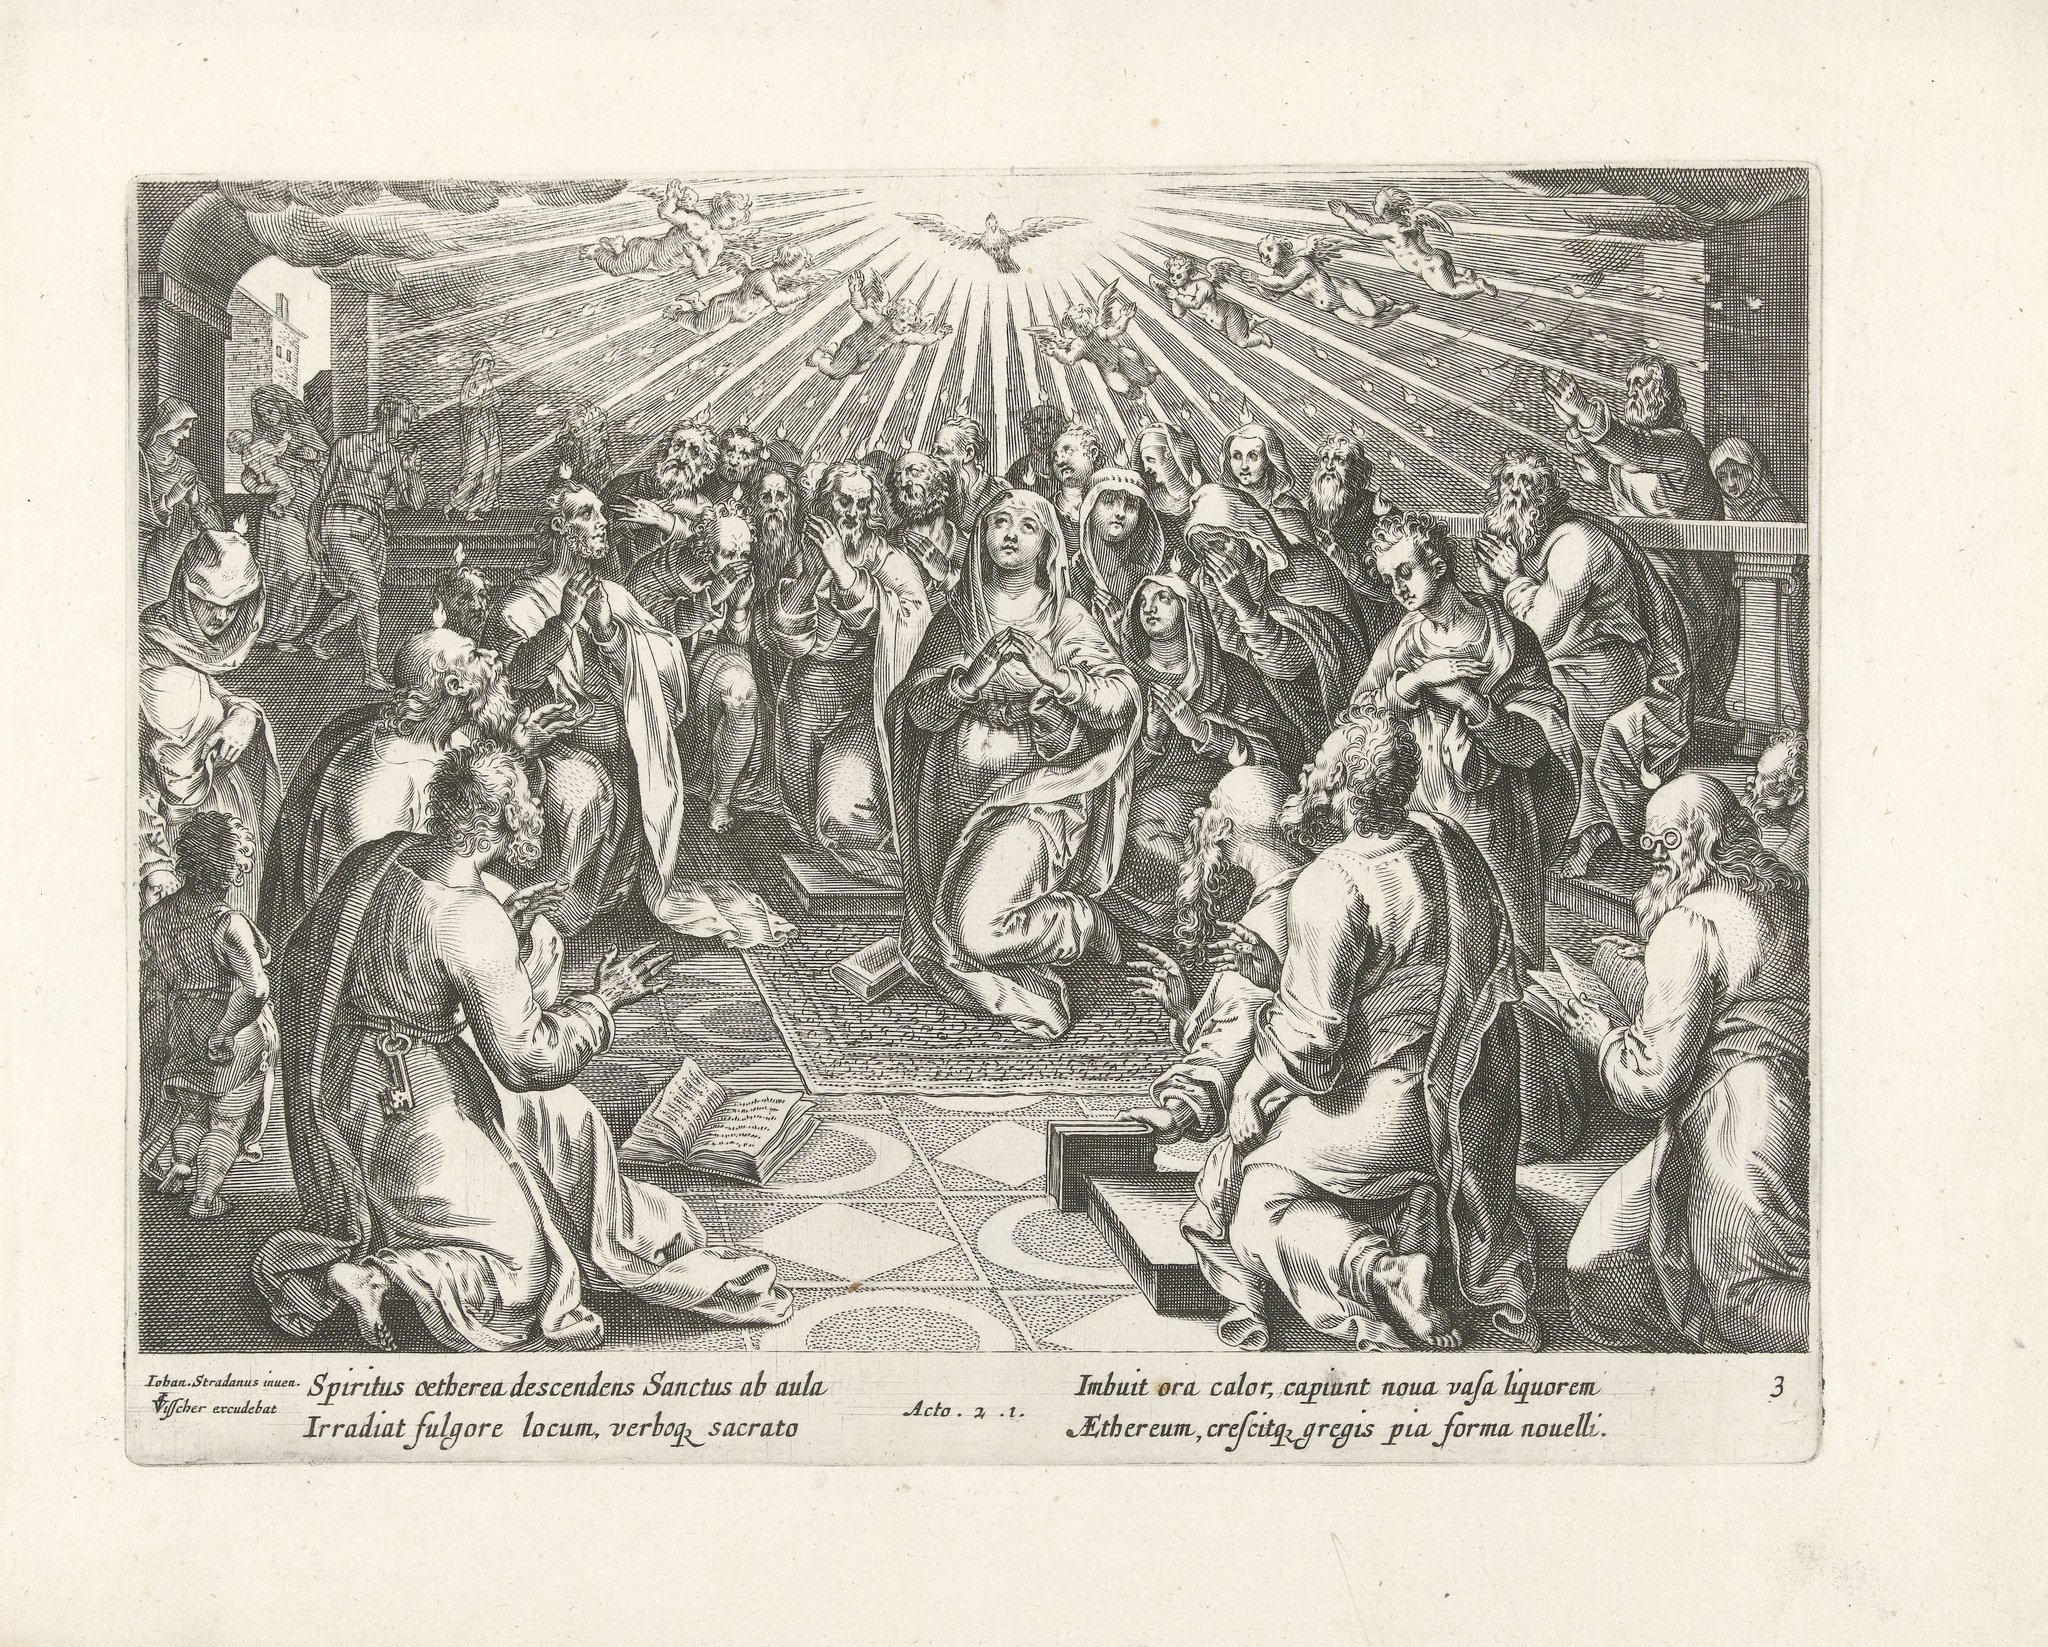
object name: print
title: Uitstorting van de Heilige Geest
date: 1643-1646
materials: paper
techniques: engraving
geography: amsterdam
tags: pentecost: the holy ghost descends upon (mary and) the apostles, sometimes paul and/or representatives of the nations present (acts 2:1-4)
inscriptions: collector's mark: Lugt 2228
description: Centraal de maagd Maria, omringd door de leerlingen van Christus. Boven hen zweeft de duif van de Heilige Geest en een engelenkoor. De prent heeft een Latijns onderschrift en maakt deel uit van een 35-delige serie met als onderwerp de Handelingen van de apostelen.